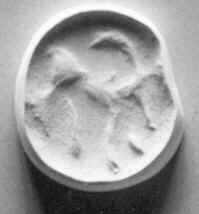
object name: stamp seal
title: Low hemispheroid seal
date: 3600-2900 BCE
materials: mineral, stone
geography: mesopotamia